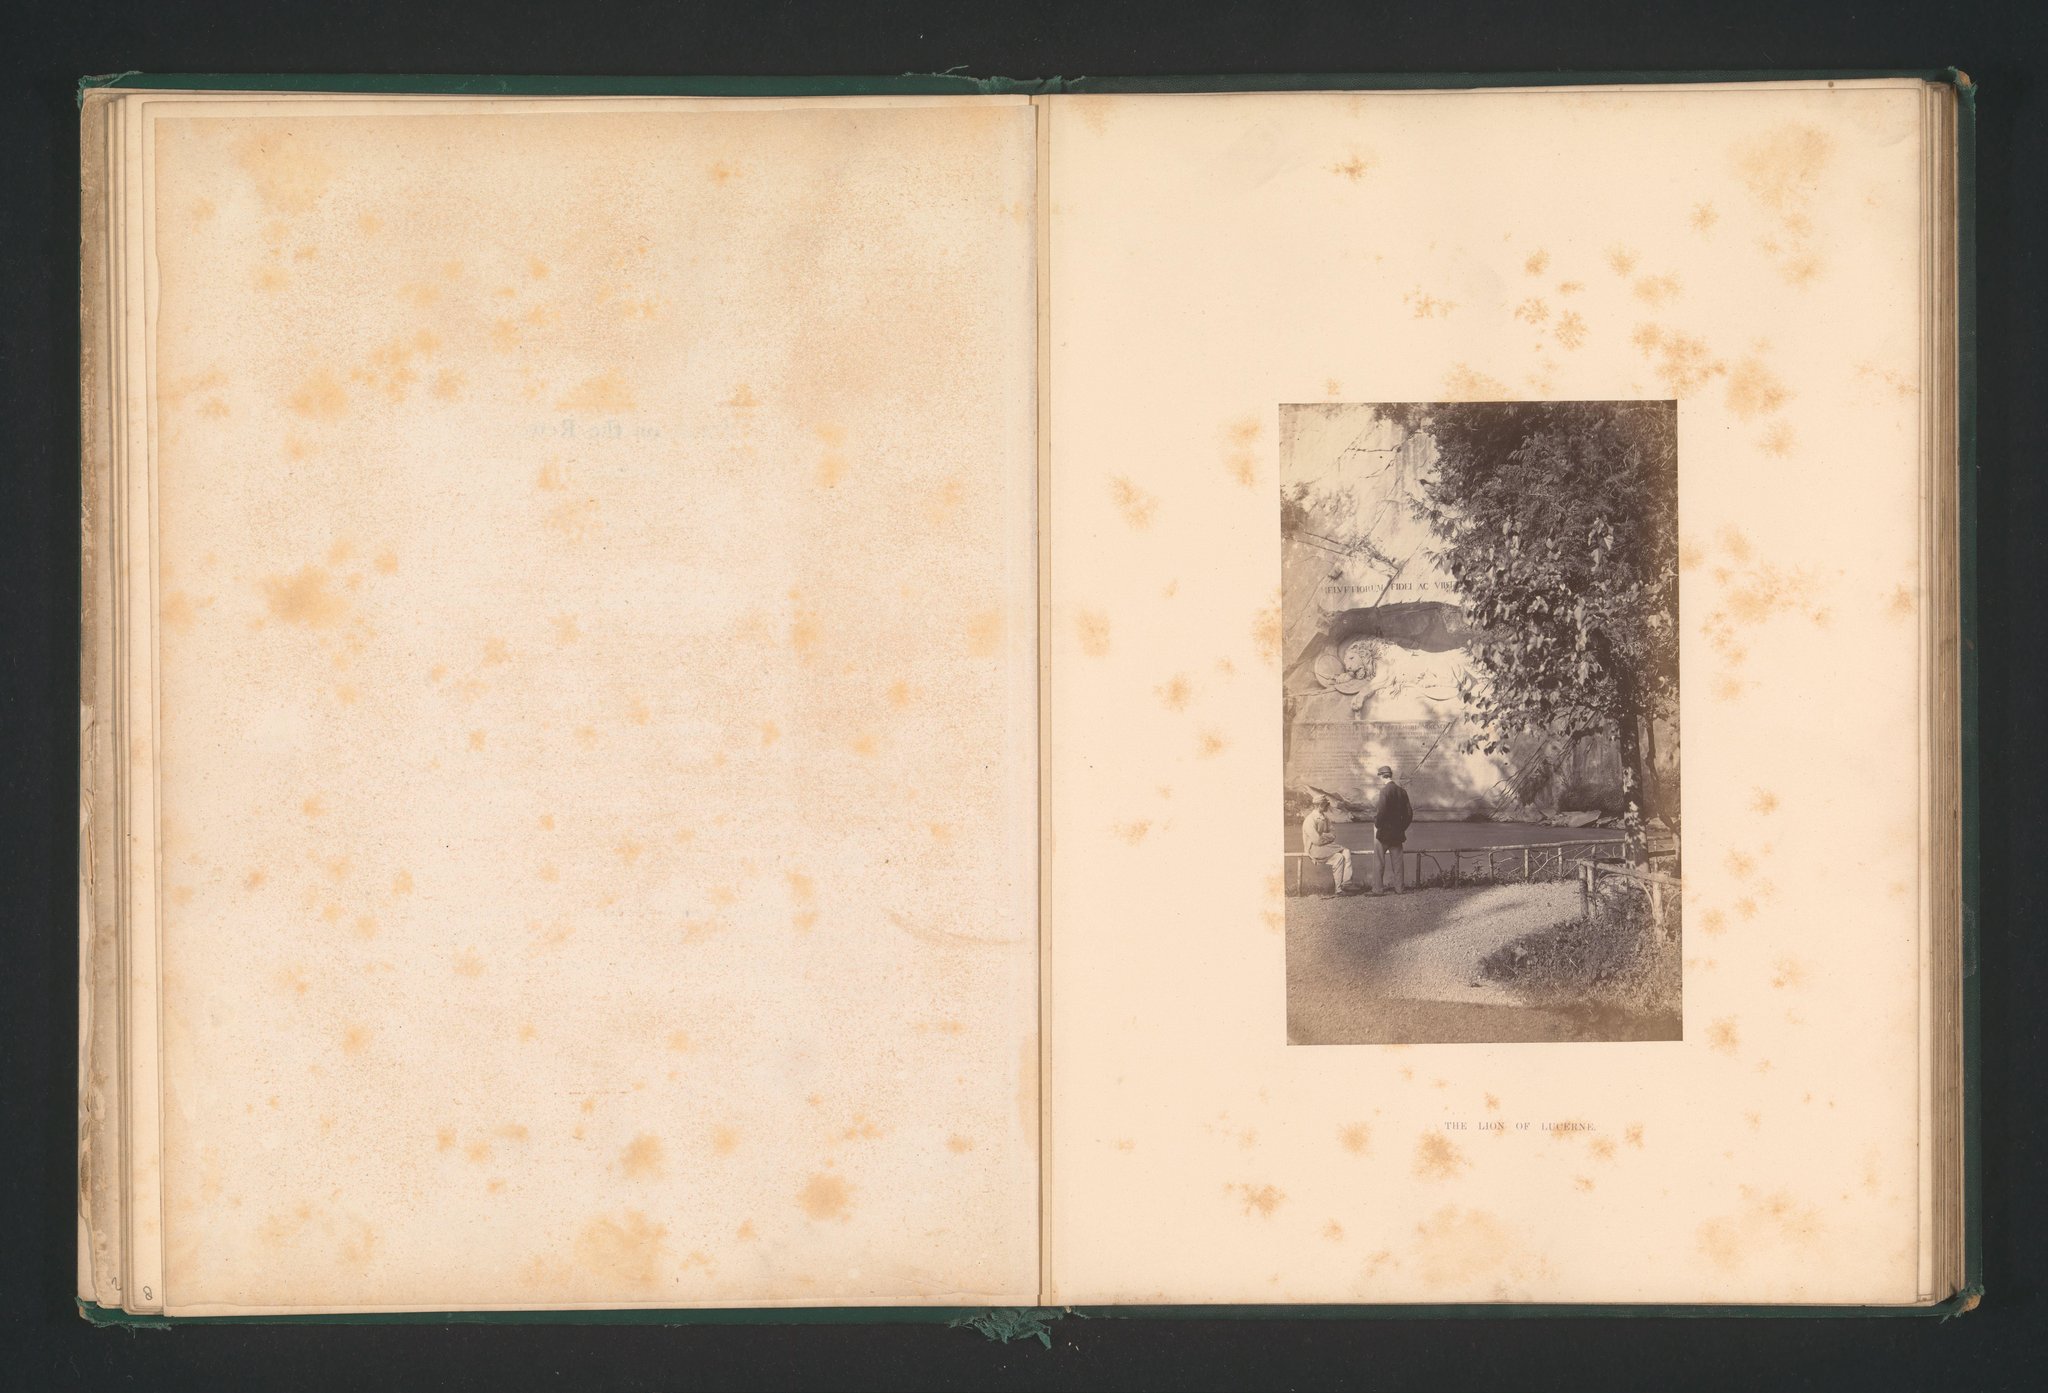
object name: photograph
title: Gezicht op de Leeuw van Luzern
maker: stephen thompson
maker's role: fotograaf, schrijver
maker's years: 1831-1893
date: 1863-1868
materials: photographic support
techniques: albumen print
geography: lucerne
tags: landscape with monument